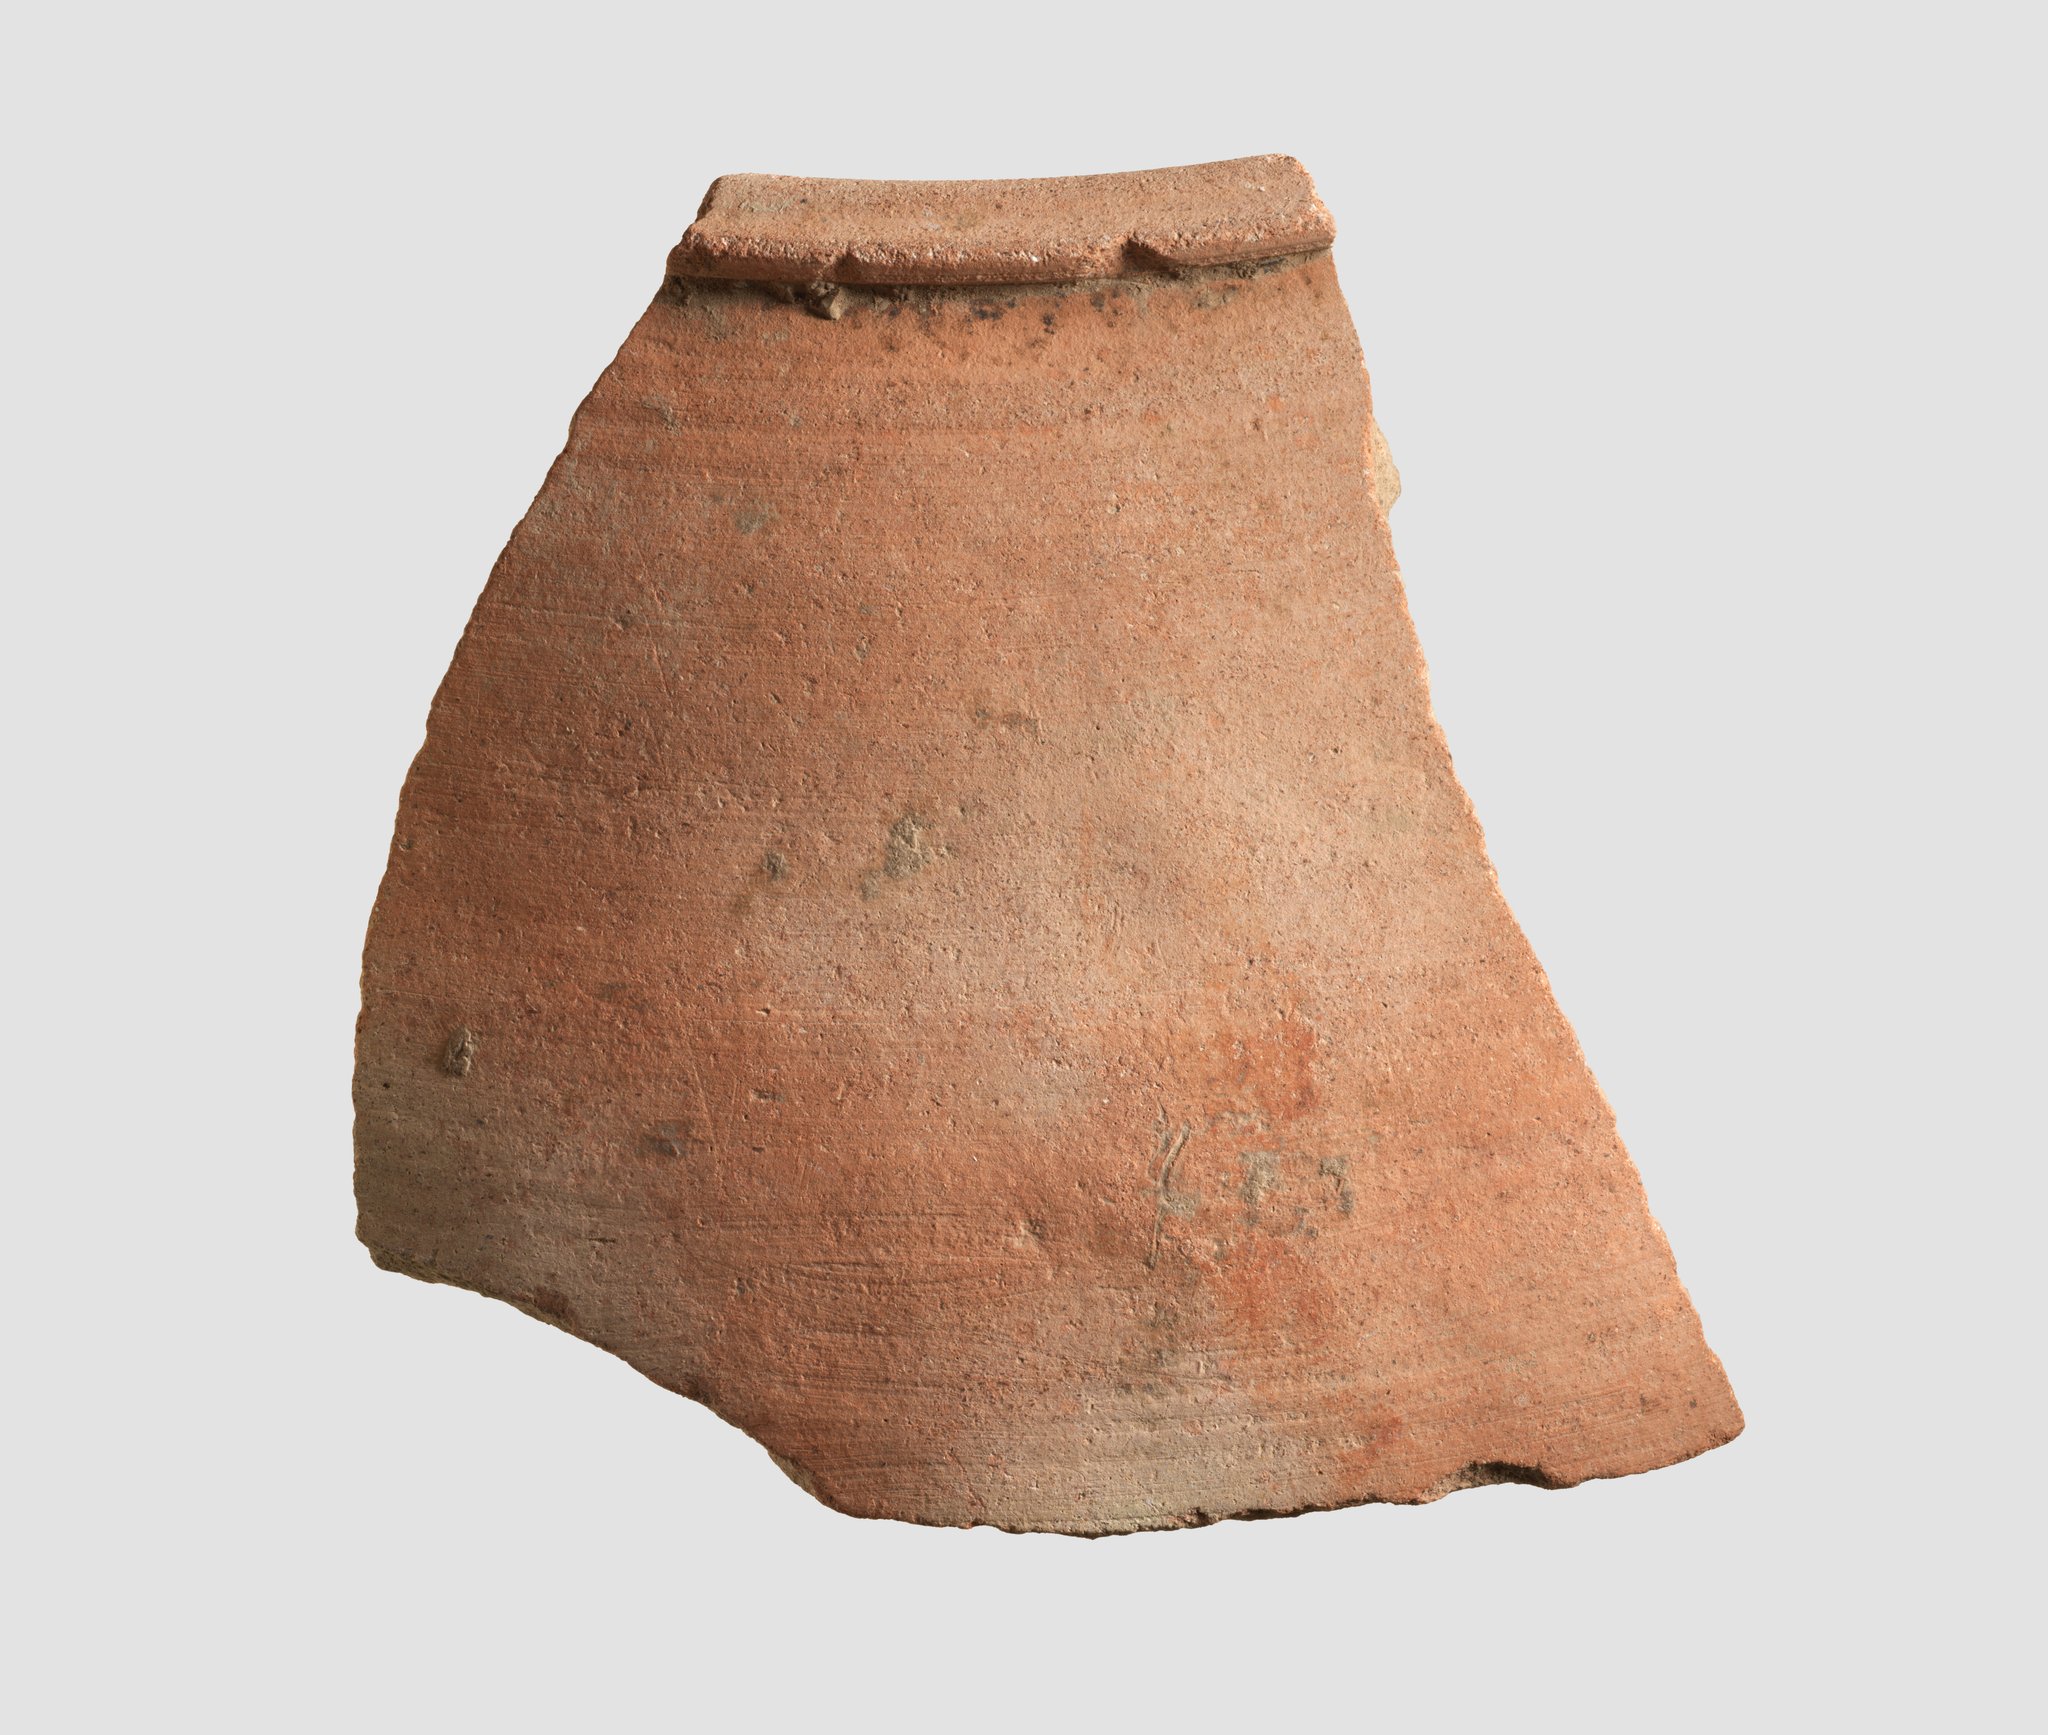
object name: sherd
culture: iranian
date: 2500-1750 BCE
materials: ceramic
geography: iran